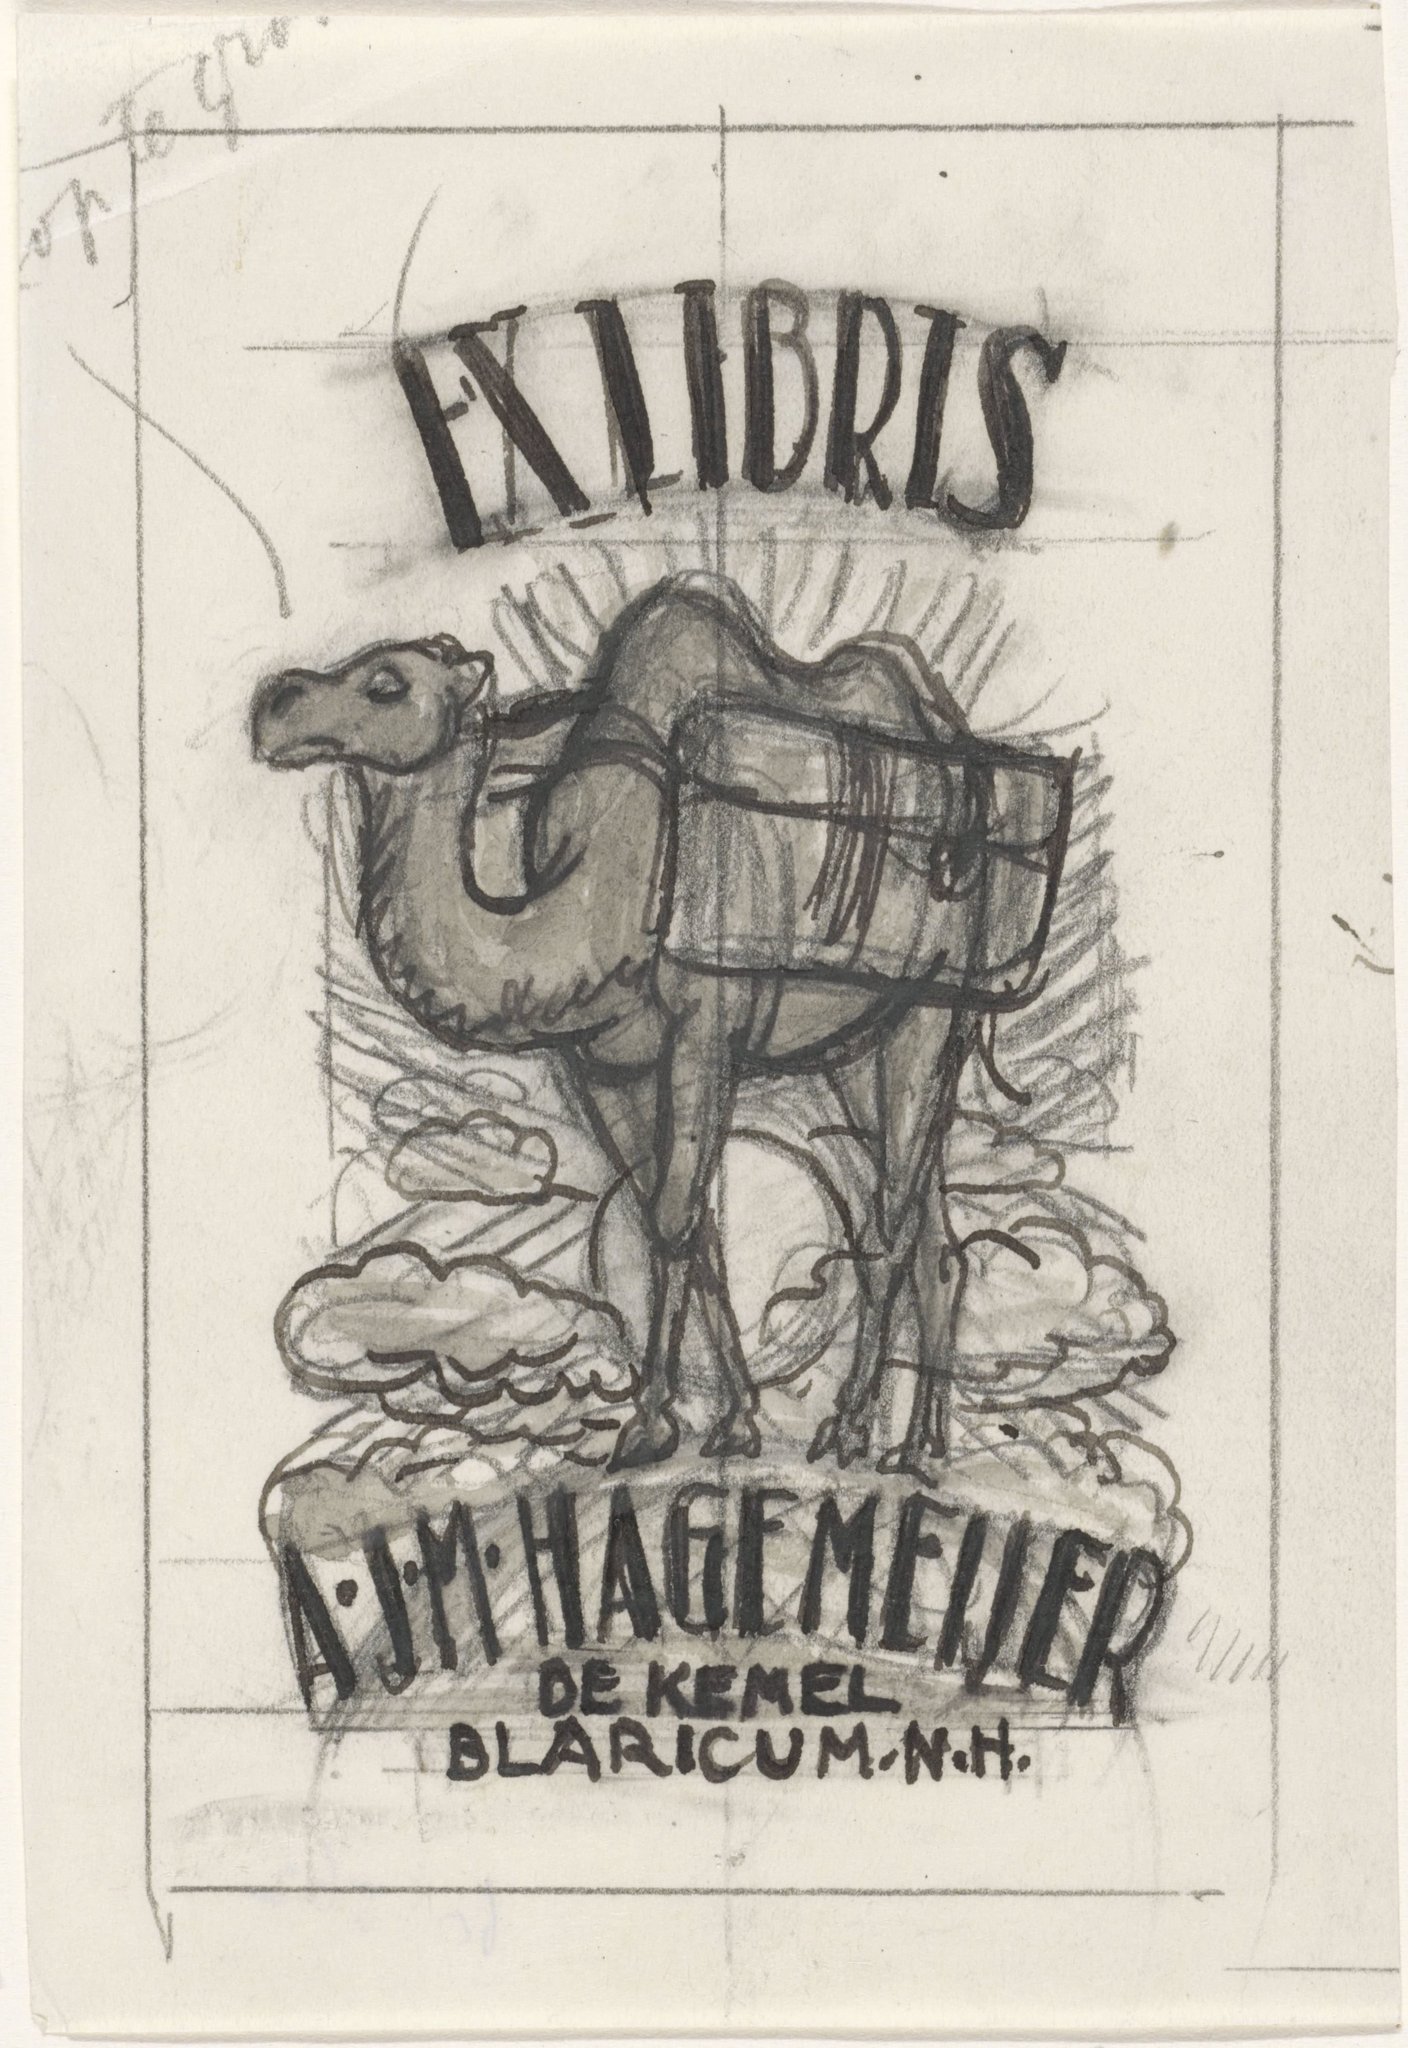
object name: design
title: Ontwerp voor een ex libris van Antonius Johannes Maria Hagemeijer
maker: leo gestel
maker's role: draughtsman, print maker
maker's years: 1881-1941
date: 1891-1941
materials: ink, paper, pencil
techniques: brush, pen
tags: hoofed animals: camel, ex-libris